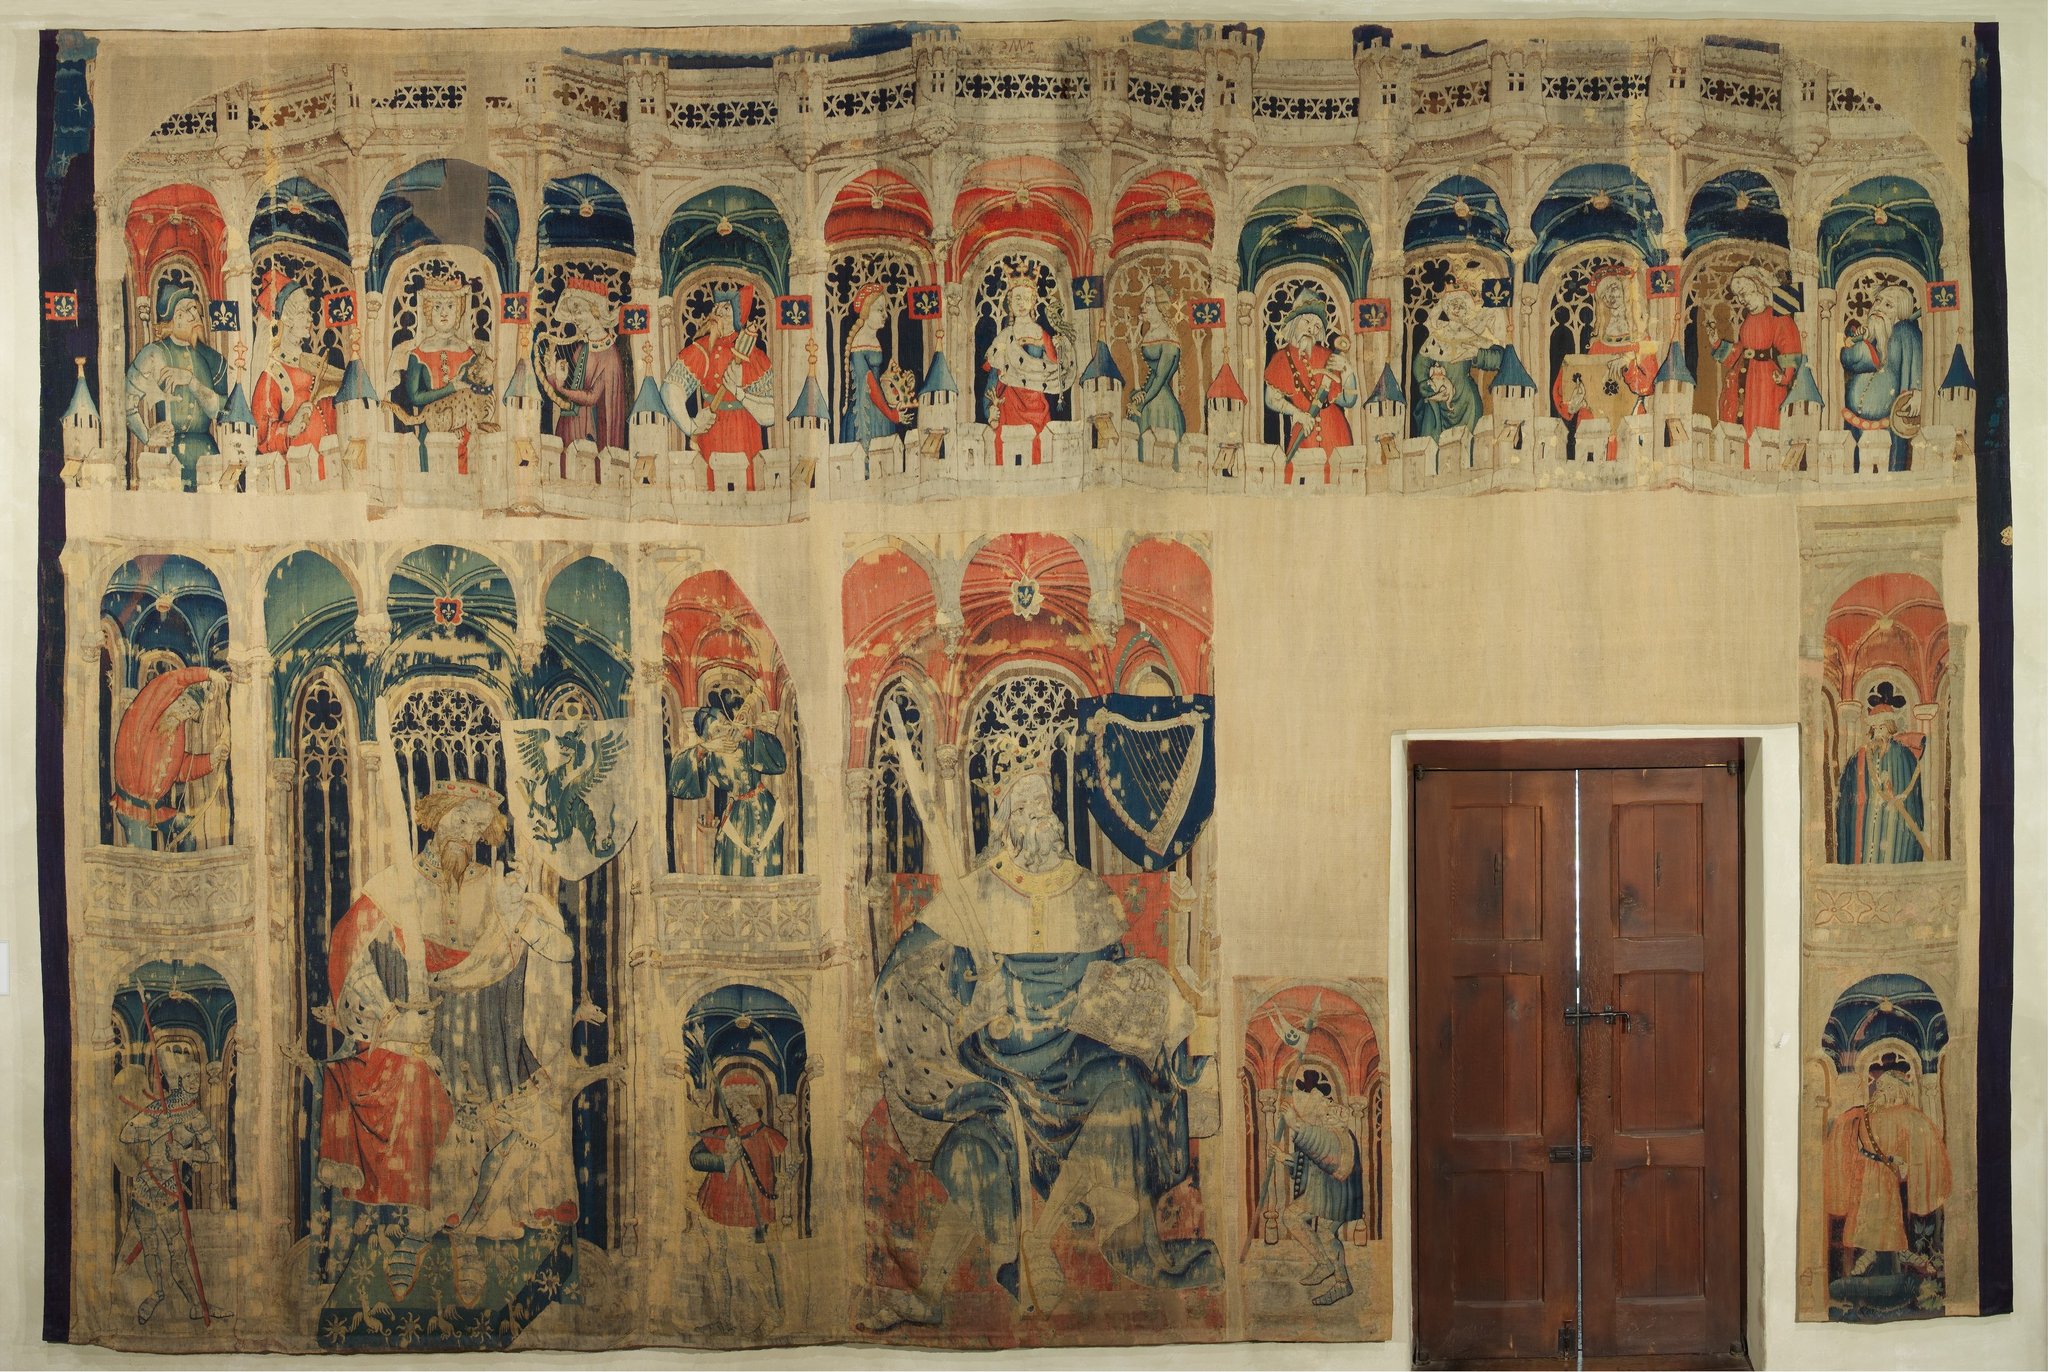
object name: tapestry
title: Joshua and David (from the Heroes Tapestries)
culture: south netherlandish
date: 1400-1410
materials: wool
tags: falcons,bow and arrow,kings,men,women,cheetahs,dogs,david,coat of arms,knights